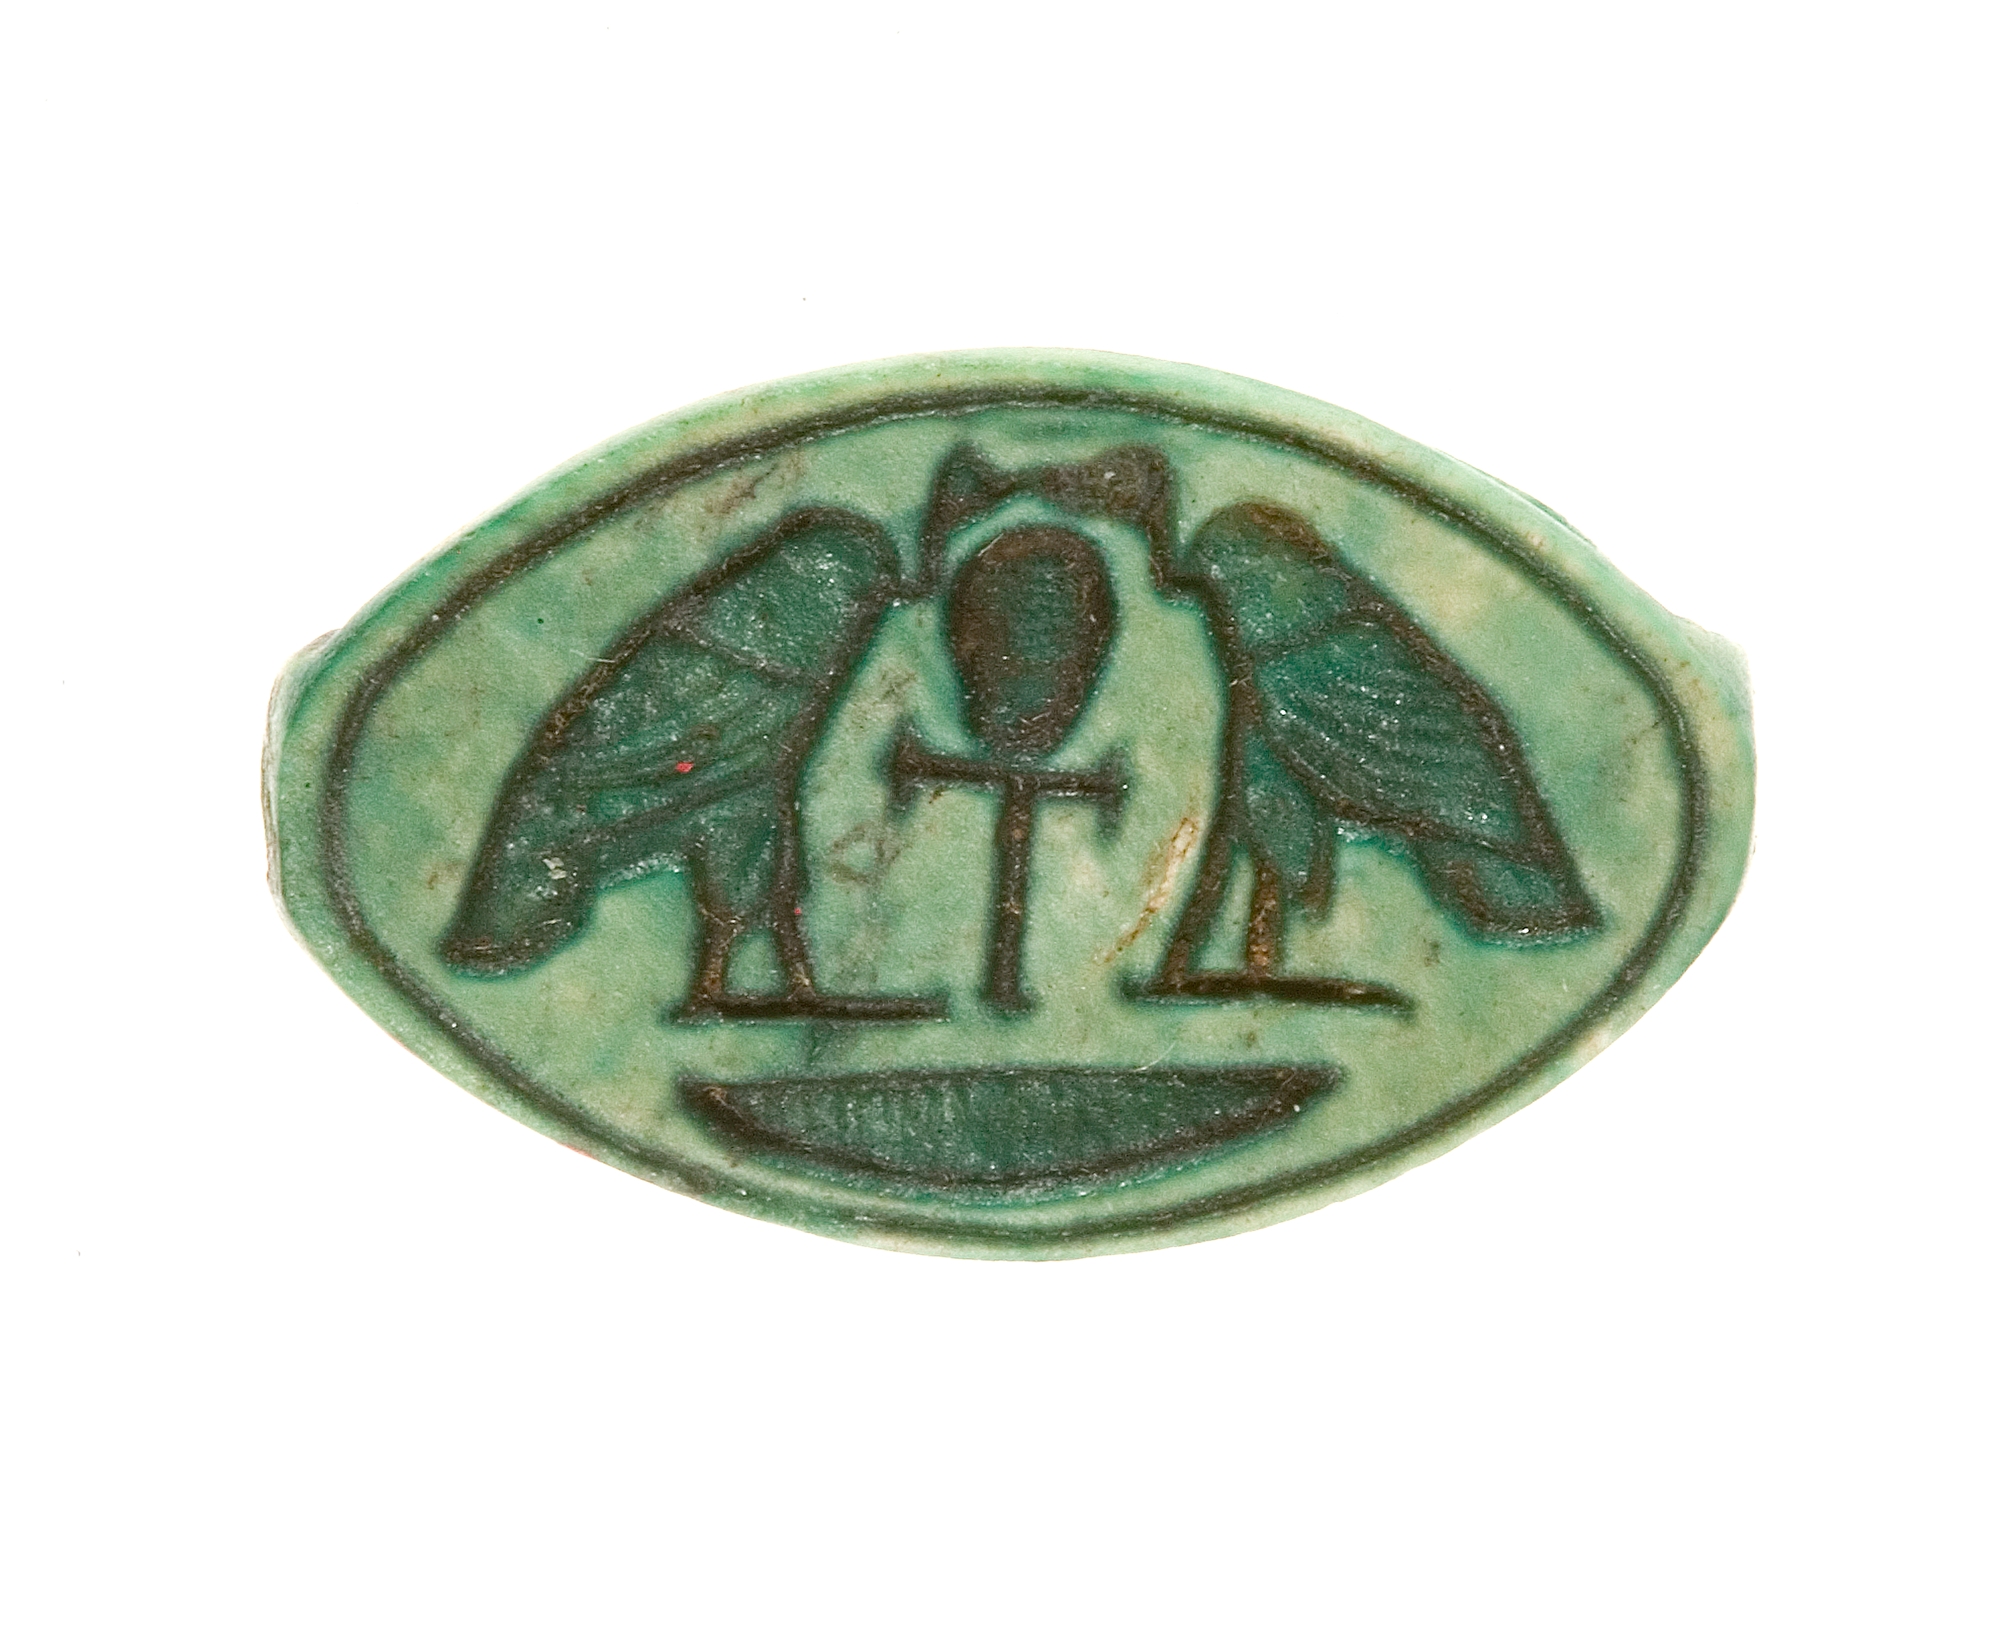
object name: cowroid, hatshepsut fd, vulture, ankh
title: Cowroid Seal Amulet Inscribed with a Hieroglyphic Motif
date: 1479-1458 BCE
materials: stone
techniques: glazing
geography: egypt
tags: hieroglyphs